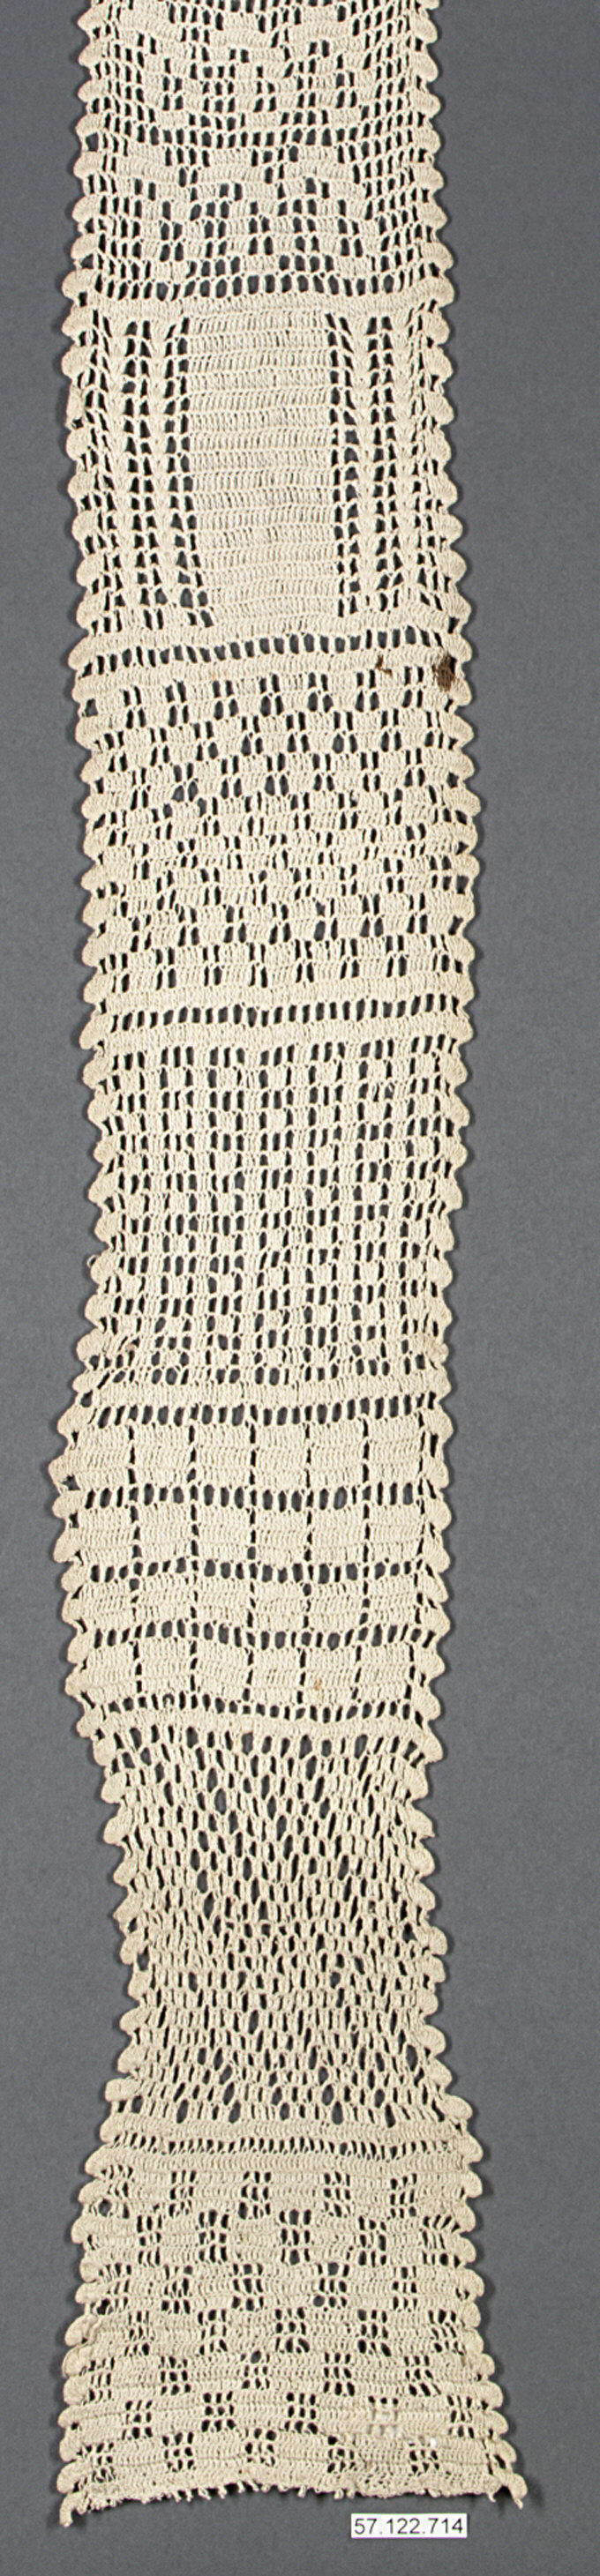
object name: sampler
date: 1801-1900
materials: cotton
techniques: crochet